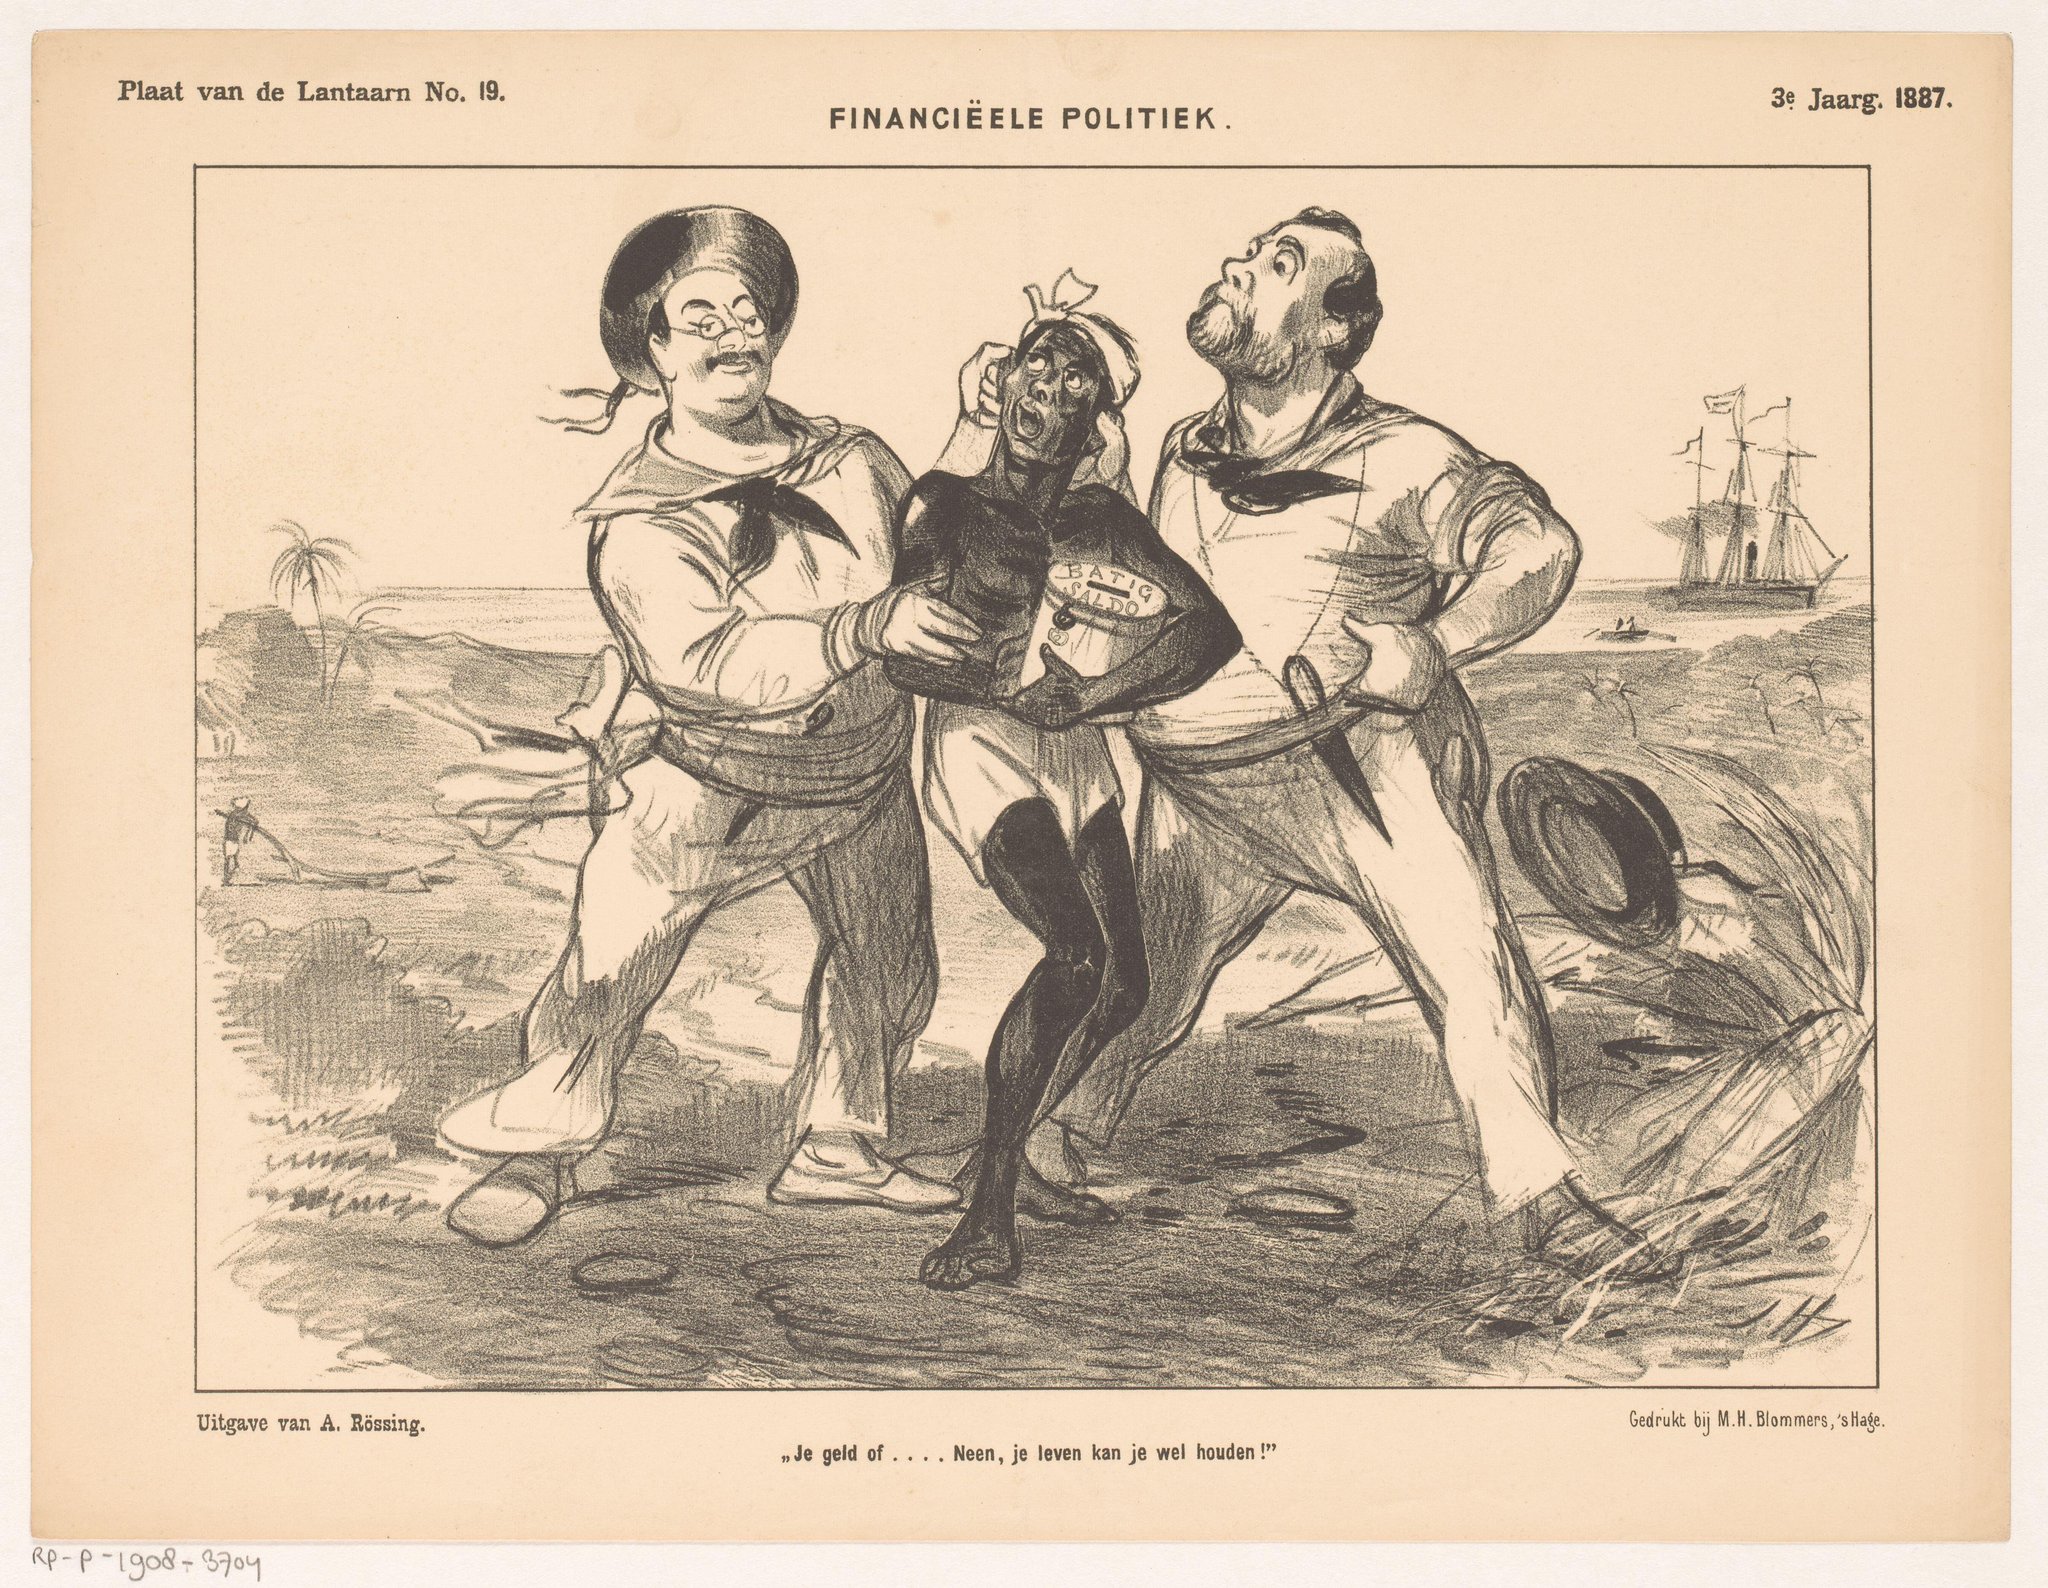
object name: print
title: Spotprent over Europese afpersing van niet-westerse landen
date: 1887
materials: paper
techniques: lithograph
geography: the hague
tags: master ~ enslaved person, money-chest, treasure-chest, money-box, political caricatures and satires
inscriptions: collector's mark: Lugt 2228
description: De mannen houden de man vast bij zijn oren. In zijn armen heeft zij een spaarpot met daarop de woorden: batig saldo. Onder de prent het citaat: "Je geld of... Neen, je leven kan je wel houden.!" Deze prent werd uitgegeven bij De Lantaarn.